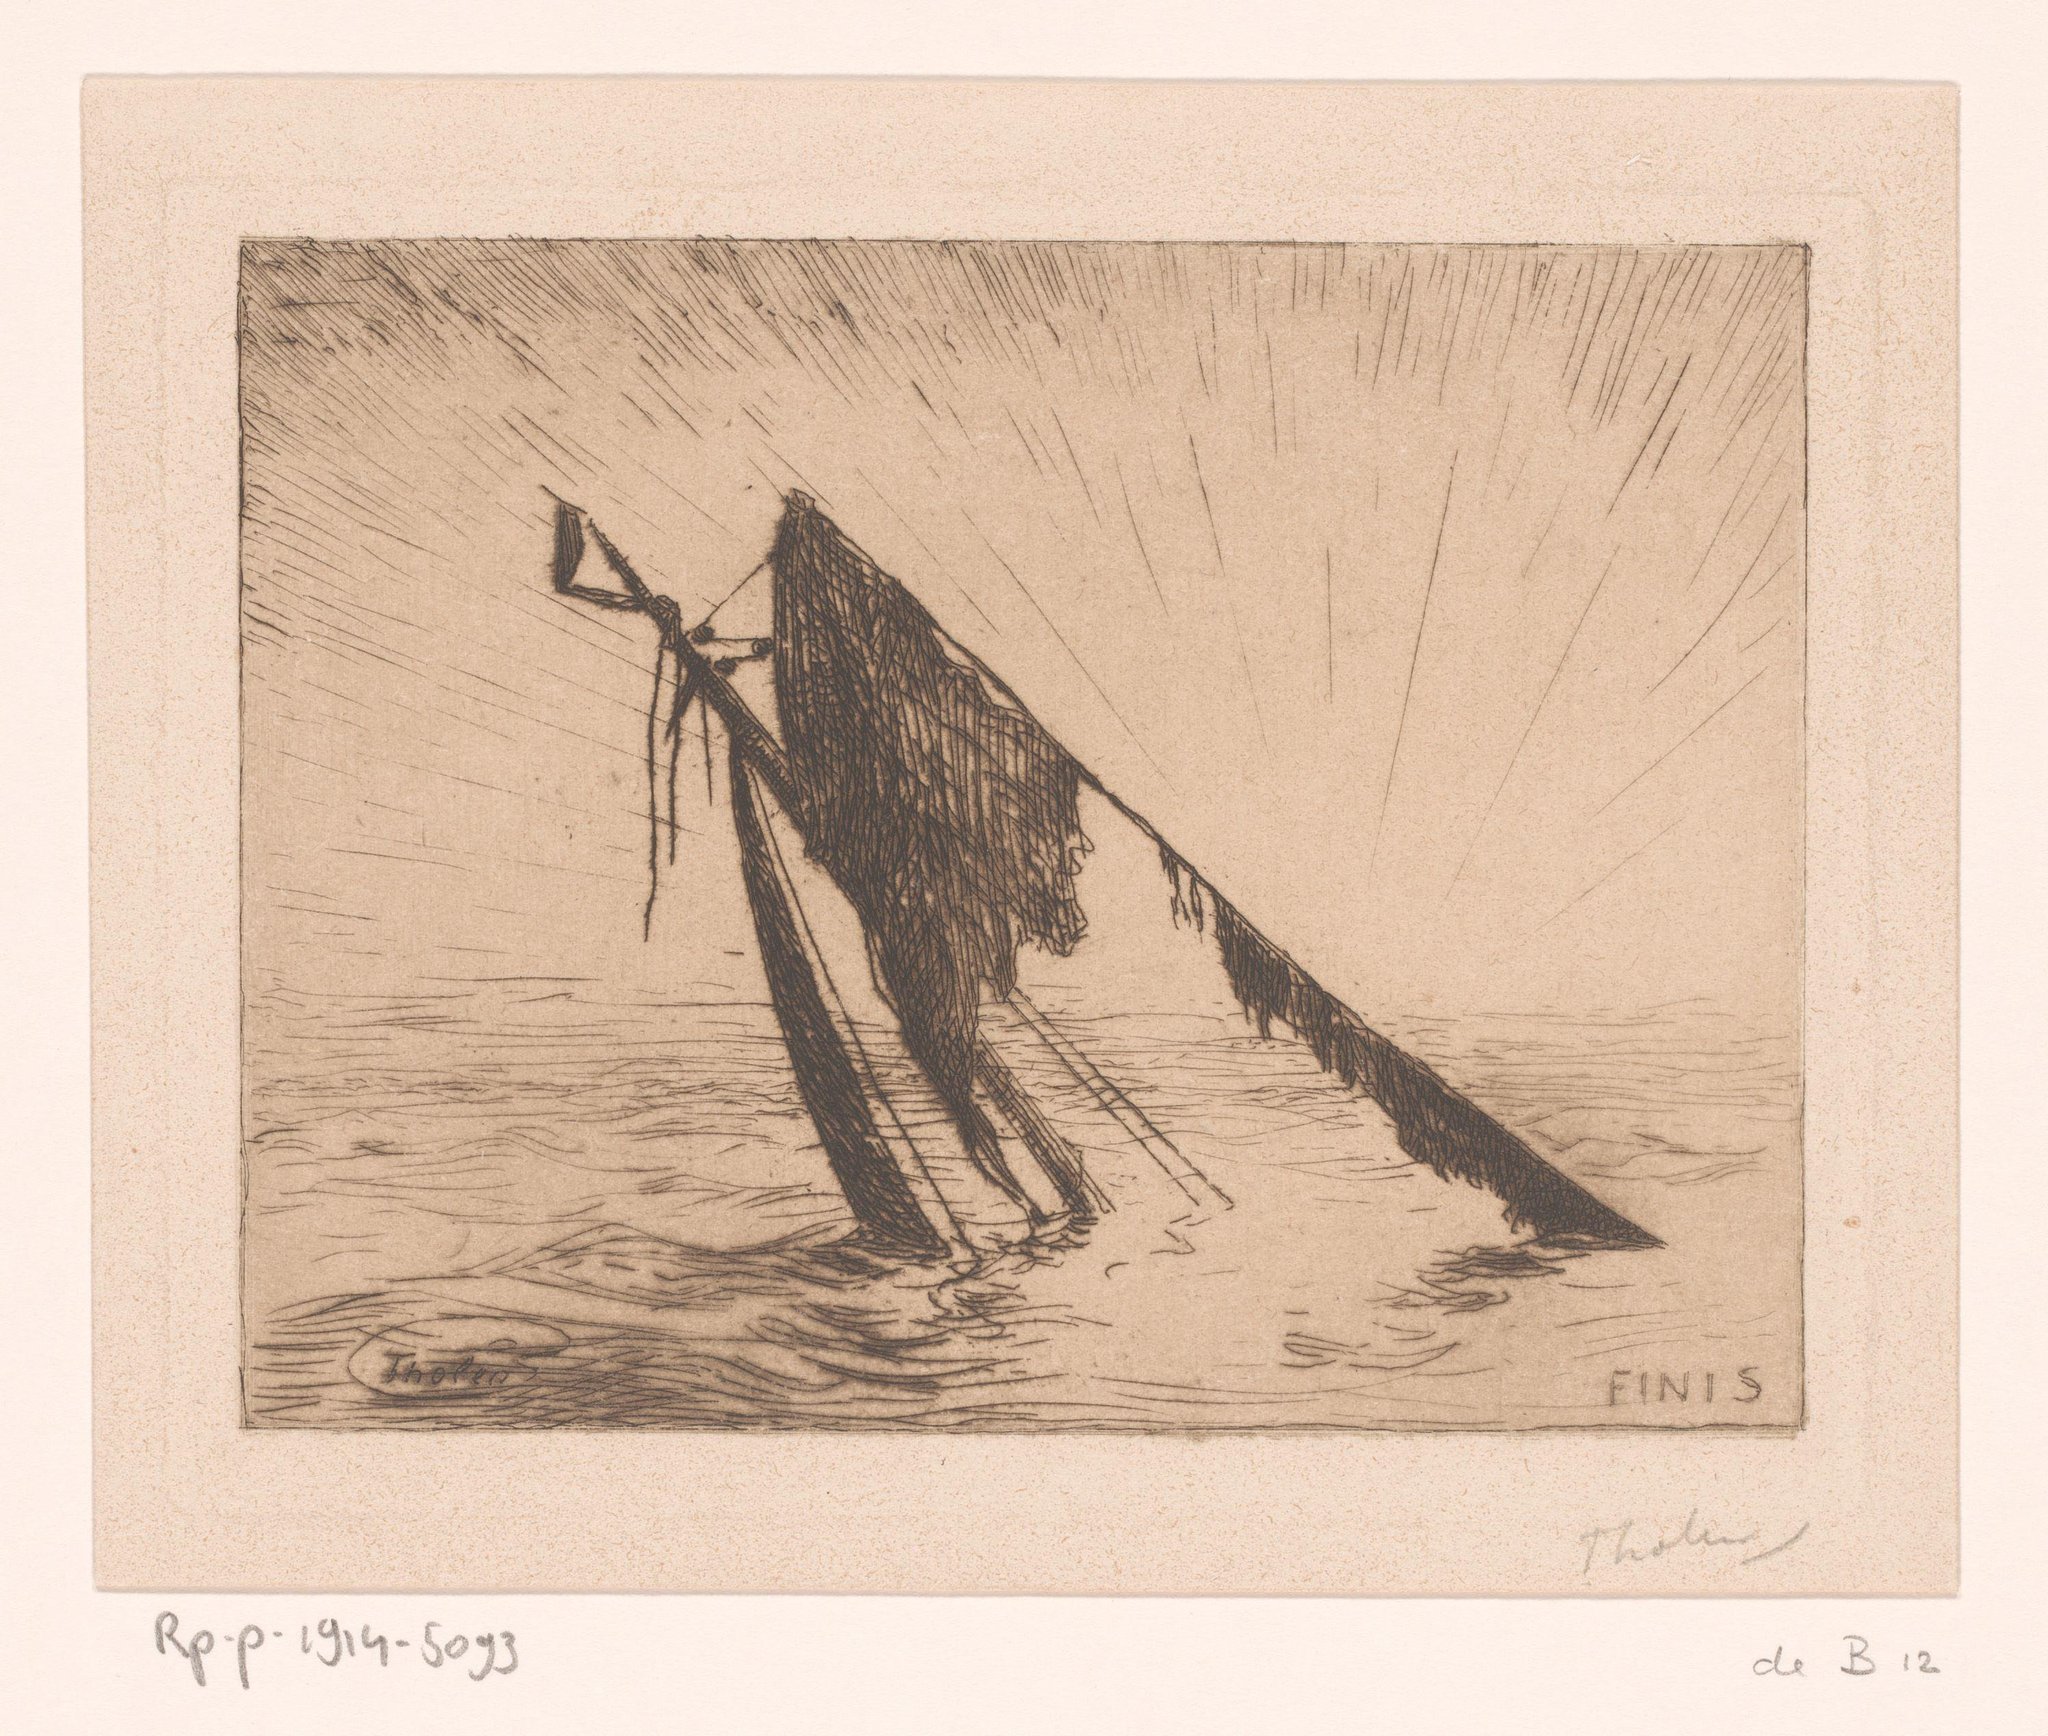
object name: print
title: Finis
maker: willem bastiaan tholen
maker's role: draughtsman, painter, print maker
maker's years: 1860-1931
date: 1870-1914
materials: paper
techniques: etching, intaglio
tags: sailing-ship, sailing-boat, sinking (movement in water)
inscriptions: collector's mark: Lugt 2233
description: Mast van een gezonken schip steekt boven het water uit.